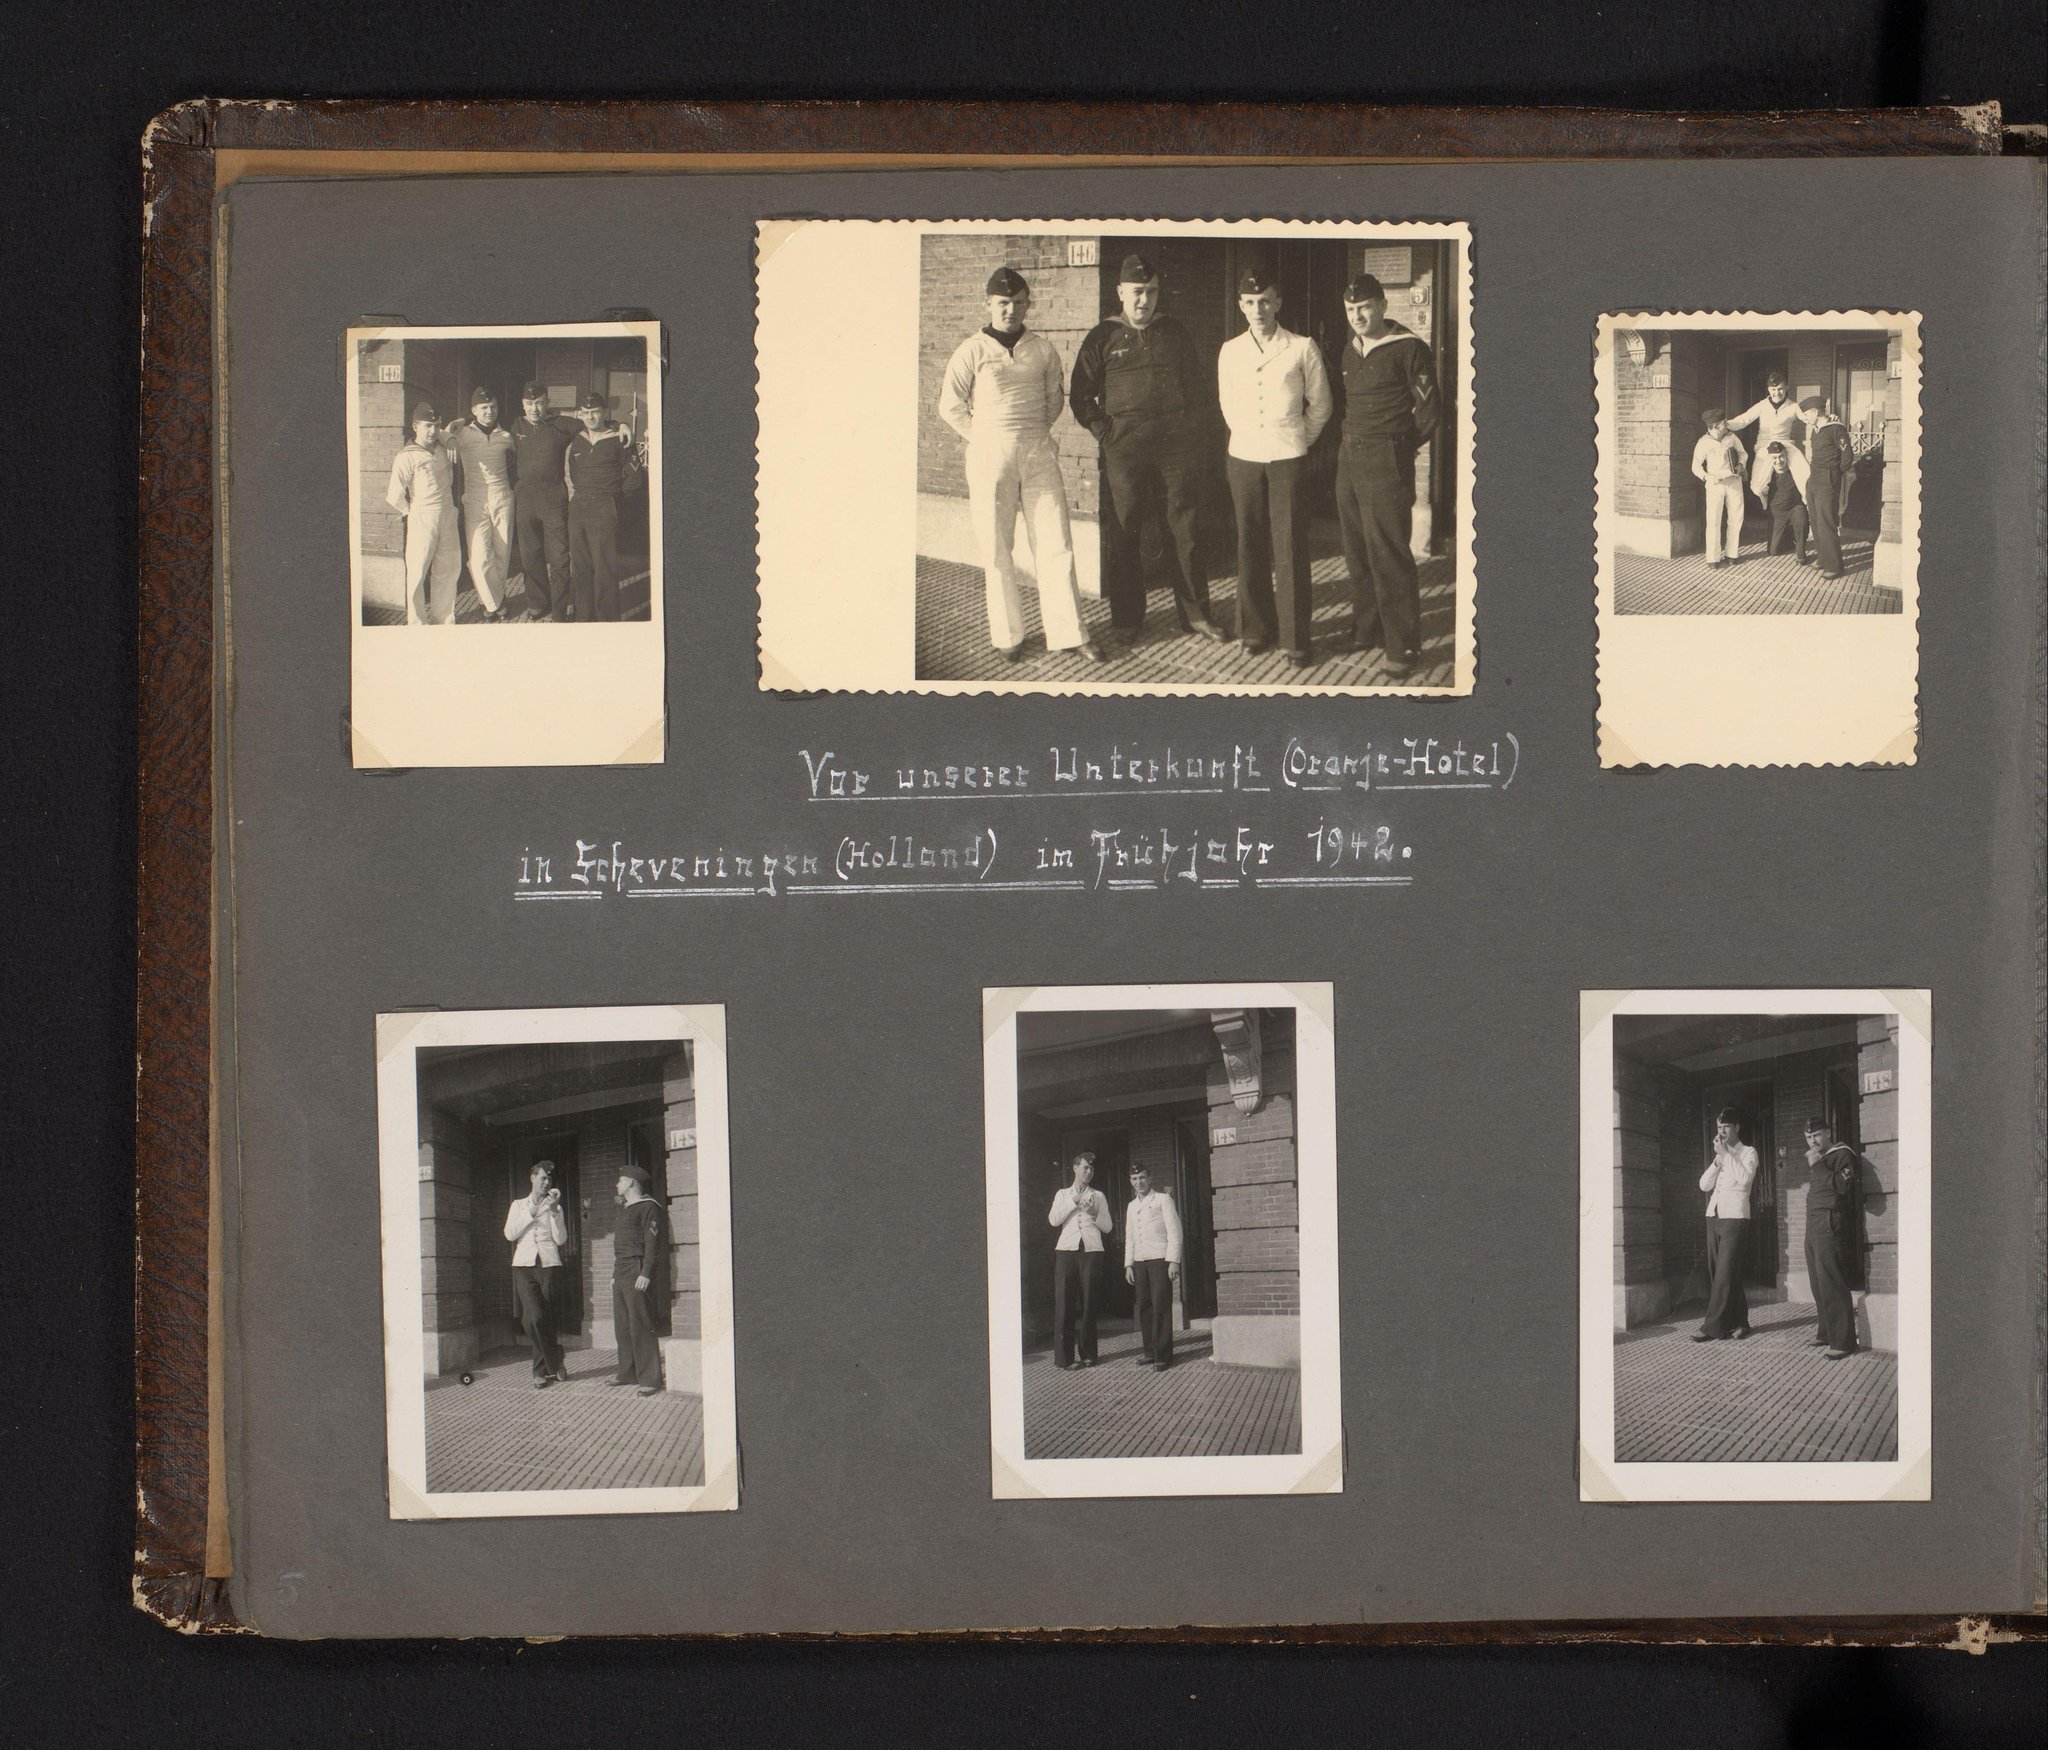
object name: photograph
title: Kriegsmarine in Scheveningen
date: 1942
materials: paper, photographic support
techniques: gelatin silver print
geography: scheveningen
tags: reinhold mohr, the company, the unit, the troop ~ military service, sailor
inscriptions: inscription: ‘Vor unserer Unterkunft (Oranje-Hotel) in Scheveningen (Holland) im Frühjahr 1942.’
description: Albumblad met zes foto's van Duitse matrozen van de Kriegsmarine, voor het Oranje-Hotel in Scheveningen, het gebouw waar ze zijn ondergebracht. Voorjaar 1942. Onderdeel van het fotoalbum Kriegsmarine.